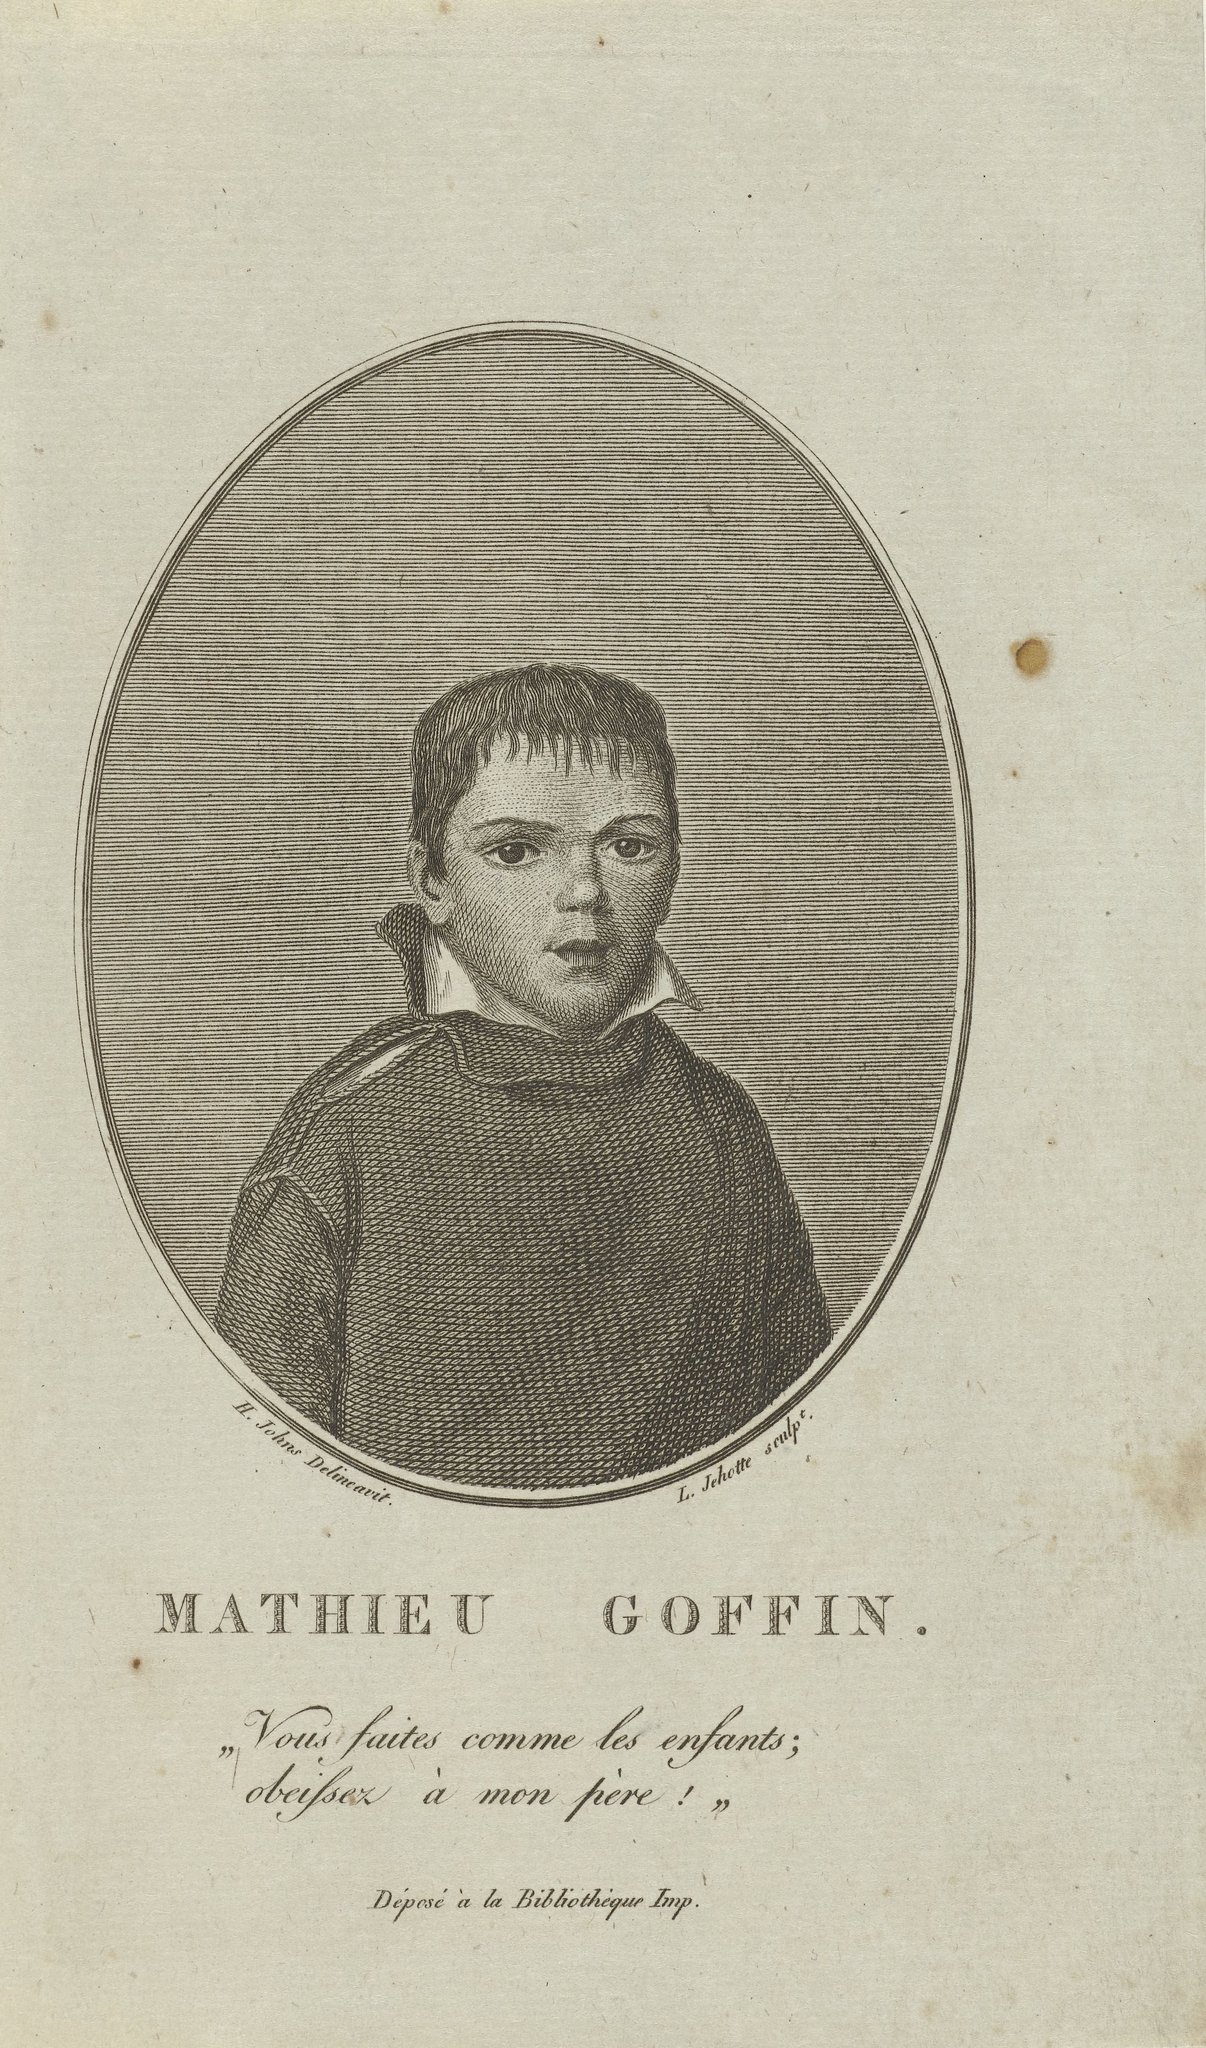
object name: print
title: Portret van Mathieu Goffin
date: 1782-1851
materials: paper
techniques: engraving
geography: southern netherlands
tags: mathieu goffin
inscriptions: collector's mark: Lugt 2228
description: Portretbuste van Mathieu Goffin, zoon van Hubert Goffin. Onder de omlijsting de naam van de geportretteerde en twee regels in het Frans.